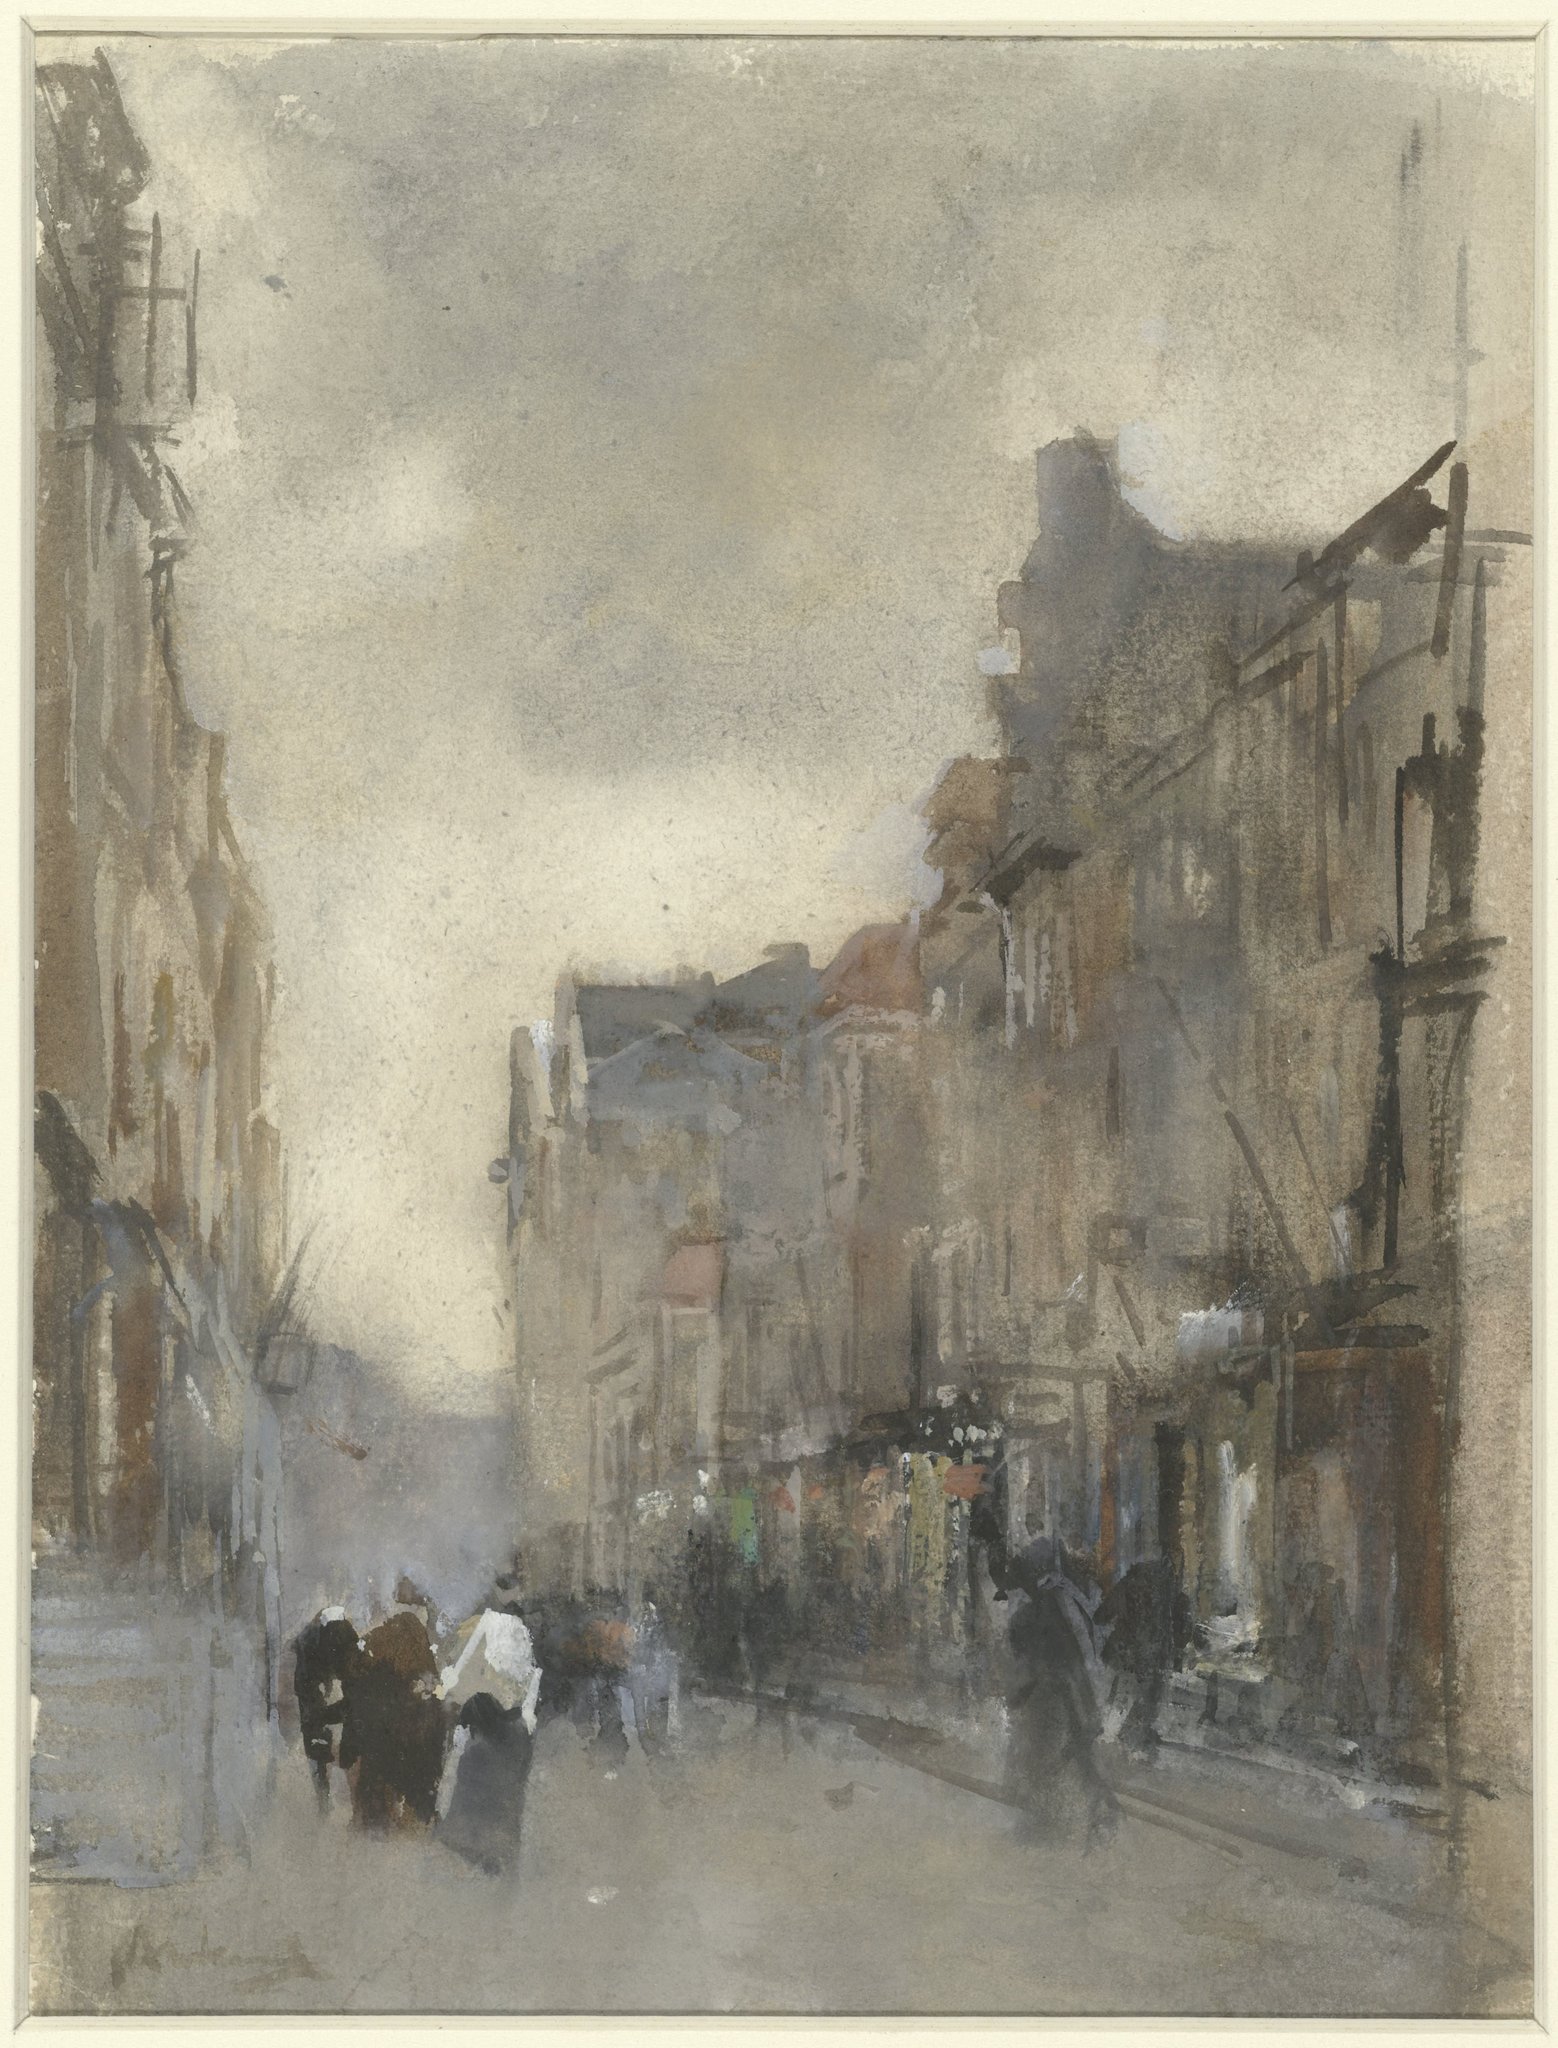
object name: drawing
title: Straatgezicht te Den Haag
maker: floris arntzenius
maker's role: draughtsman, print maker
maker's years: 1864-1925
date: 1874-1925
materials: chalk, paper, watercolor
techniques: brush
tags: street, the hague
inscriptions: signature: ‘Arntzenius’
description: Straatgezicht met enkele voetgangers, schetsmatig weergegeven.